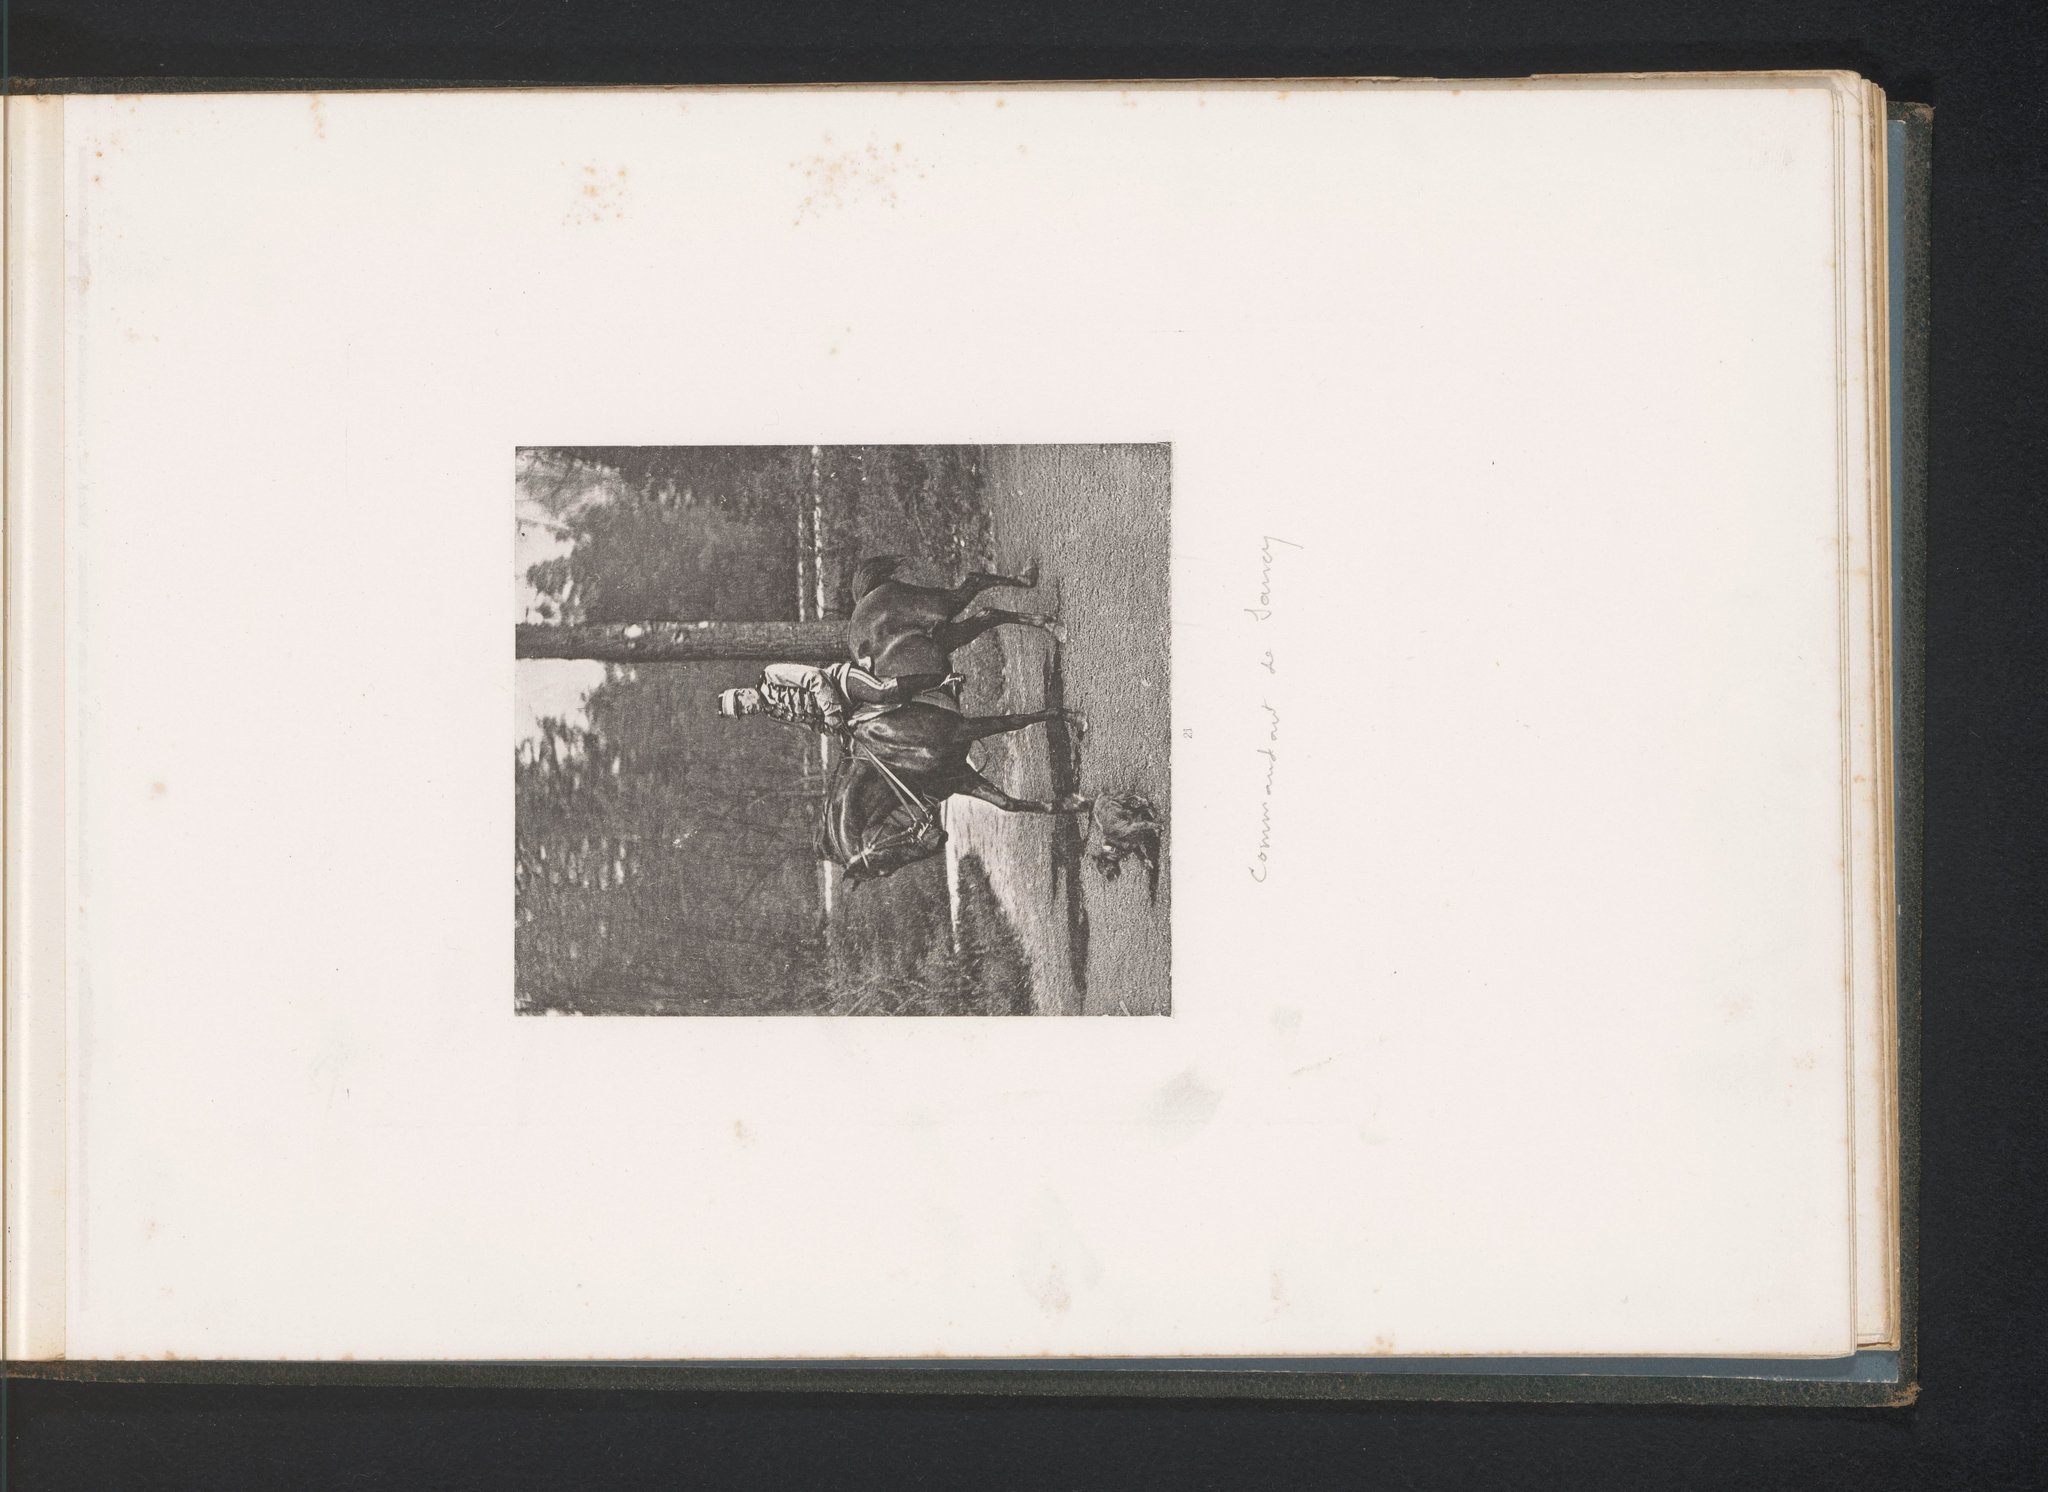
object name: photomechanical print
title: Commandant te paard met een hond ervoor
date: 1874-1884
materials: paper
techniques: photoaquatint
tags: riding a horse, ass, or mule; rider, horseman, (military) uniforms, dog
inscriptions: number: ‘21’, inscription: ‘Commandant de Sancy’